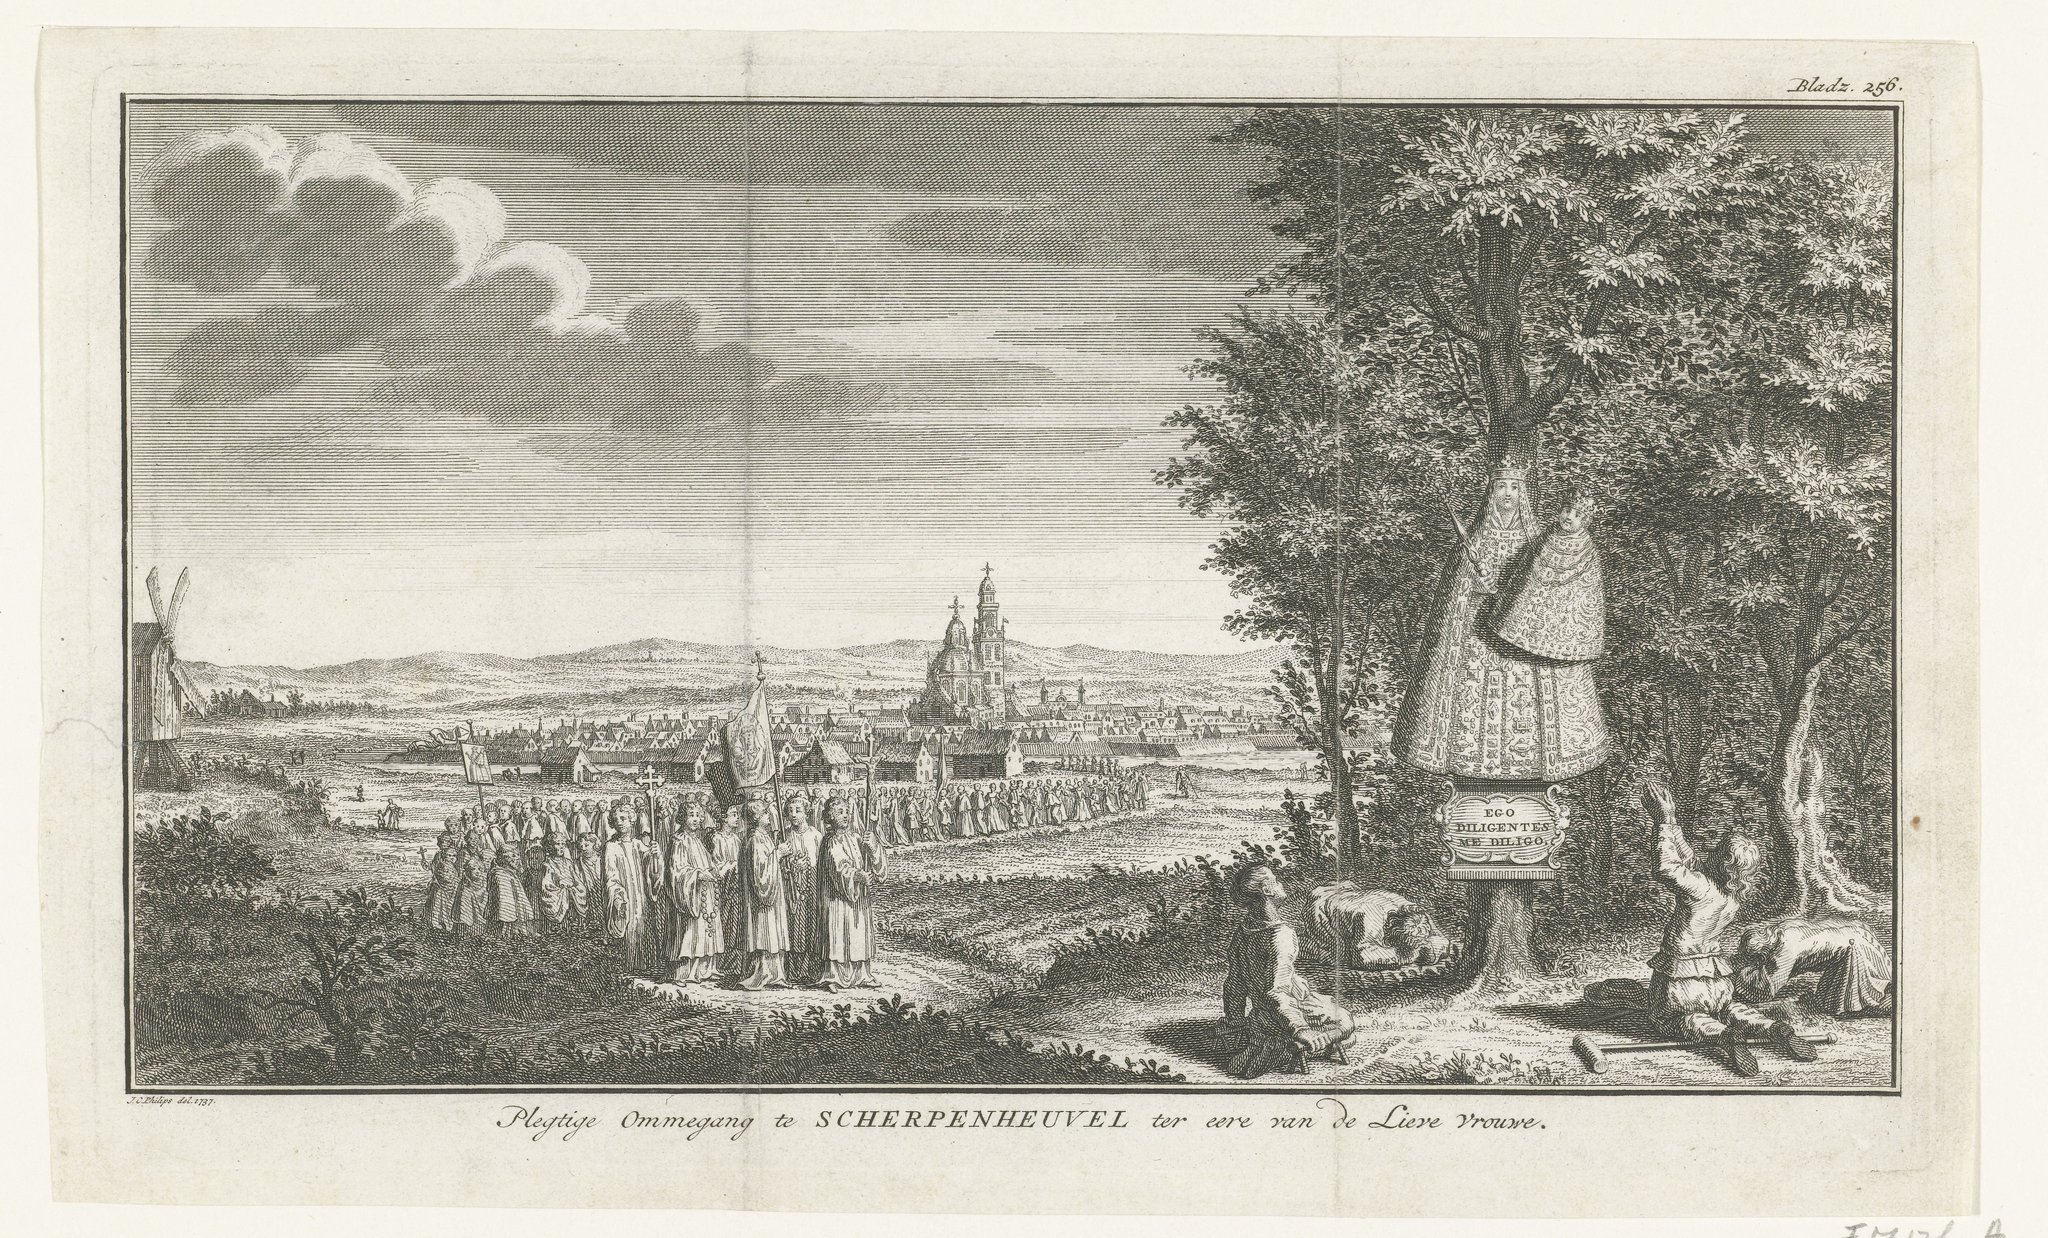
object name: print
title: Processie naar Mariabeeld te Scherpenheuvel, 1637 (?)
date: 1737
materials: paper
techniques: etching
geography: northern netherlands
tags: crutches, procession ~ roman religion, scherpenheuvel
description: Landschap met een processie, de jaarlijkse ommegang, vanuit het dorp Scherpenheuvel naar een beeld van Maria met kind wat bij een bomengroepje staat. Bij het beeld bidden enkele mensen die krukken naast zich hebben liggen. Mogelijk rond 1637.